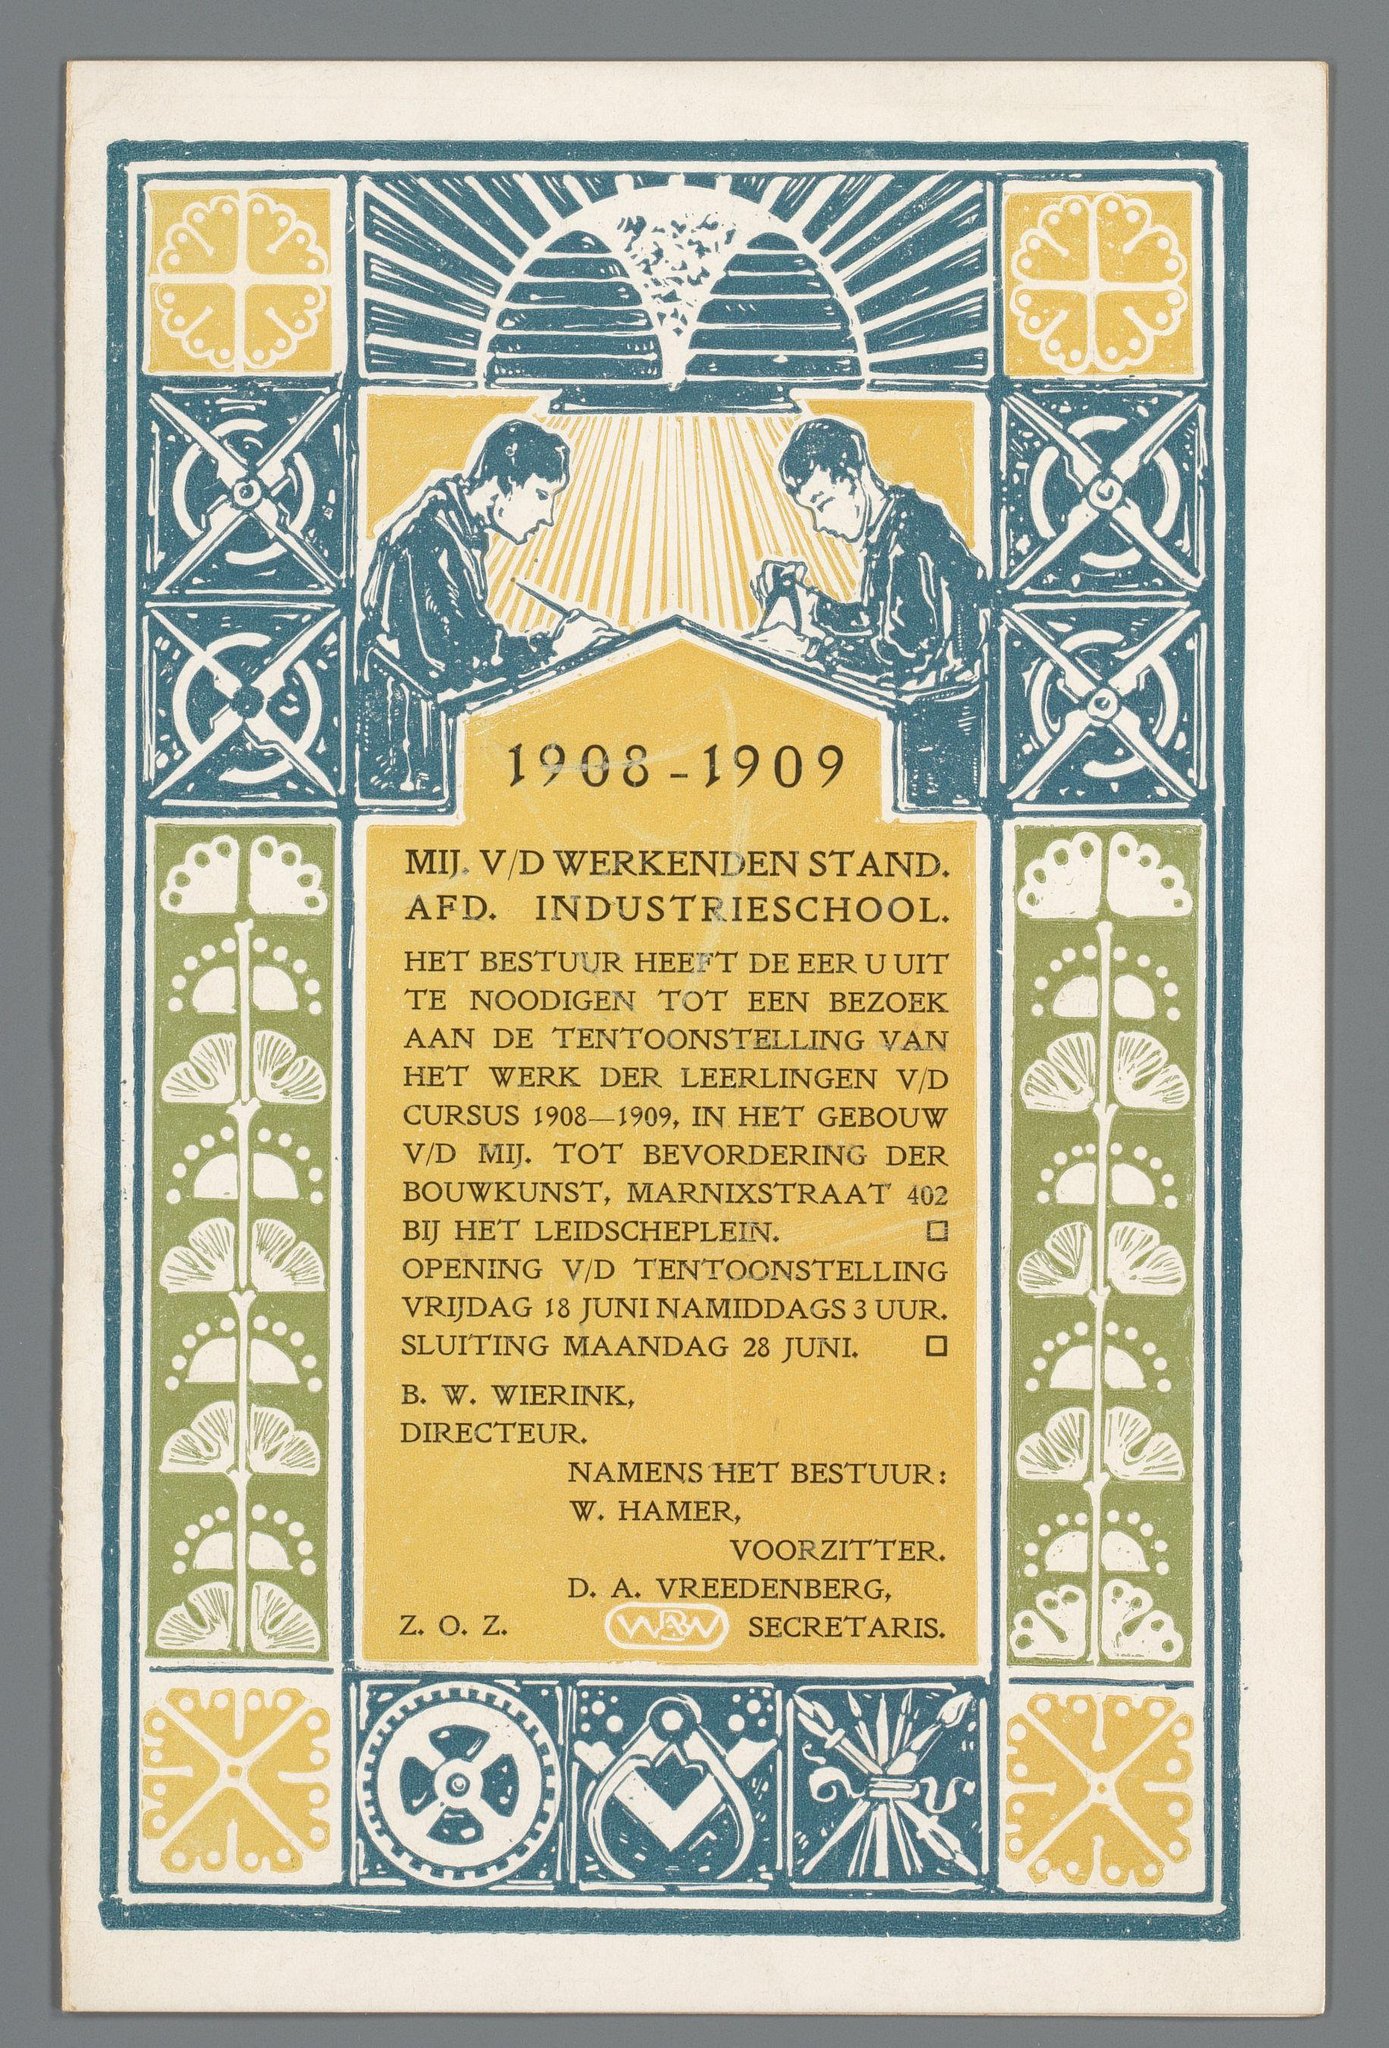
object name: invitation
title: Uitnodiging voor de tentoonstelling van werk van de leerlingen van de Afdeling Industrieschool van de Maatschappij voor den Werkenden Stand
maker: bernard willem wierink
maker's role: draughtsman, print maker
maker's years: 1856-1939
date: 1909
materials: paper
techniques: lithograph, letterpress printing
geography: amsterdam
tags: compasses, collection, exhibition, show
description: Onder een gespiegelde bijenkorf zitten twee mannen aan tafel te werken, de een met een passer de ander met een potlood. Rechts en links decoratieve kaders met onder andere ginkgobladeren en tekengereedschap. In het midden een beschrijvende tekst over de tentoonstelling. Binnenin de kaart een beschrijving van de cursussen bij de Maatschappij voor den Werkenden Stand, Afdeling Industrieschool.